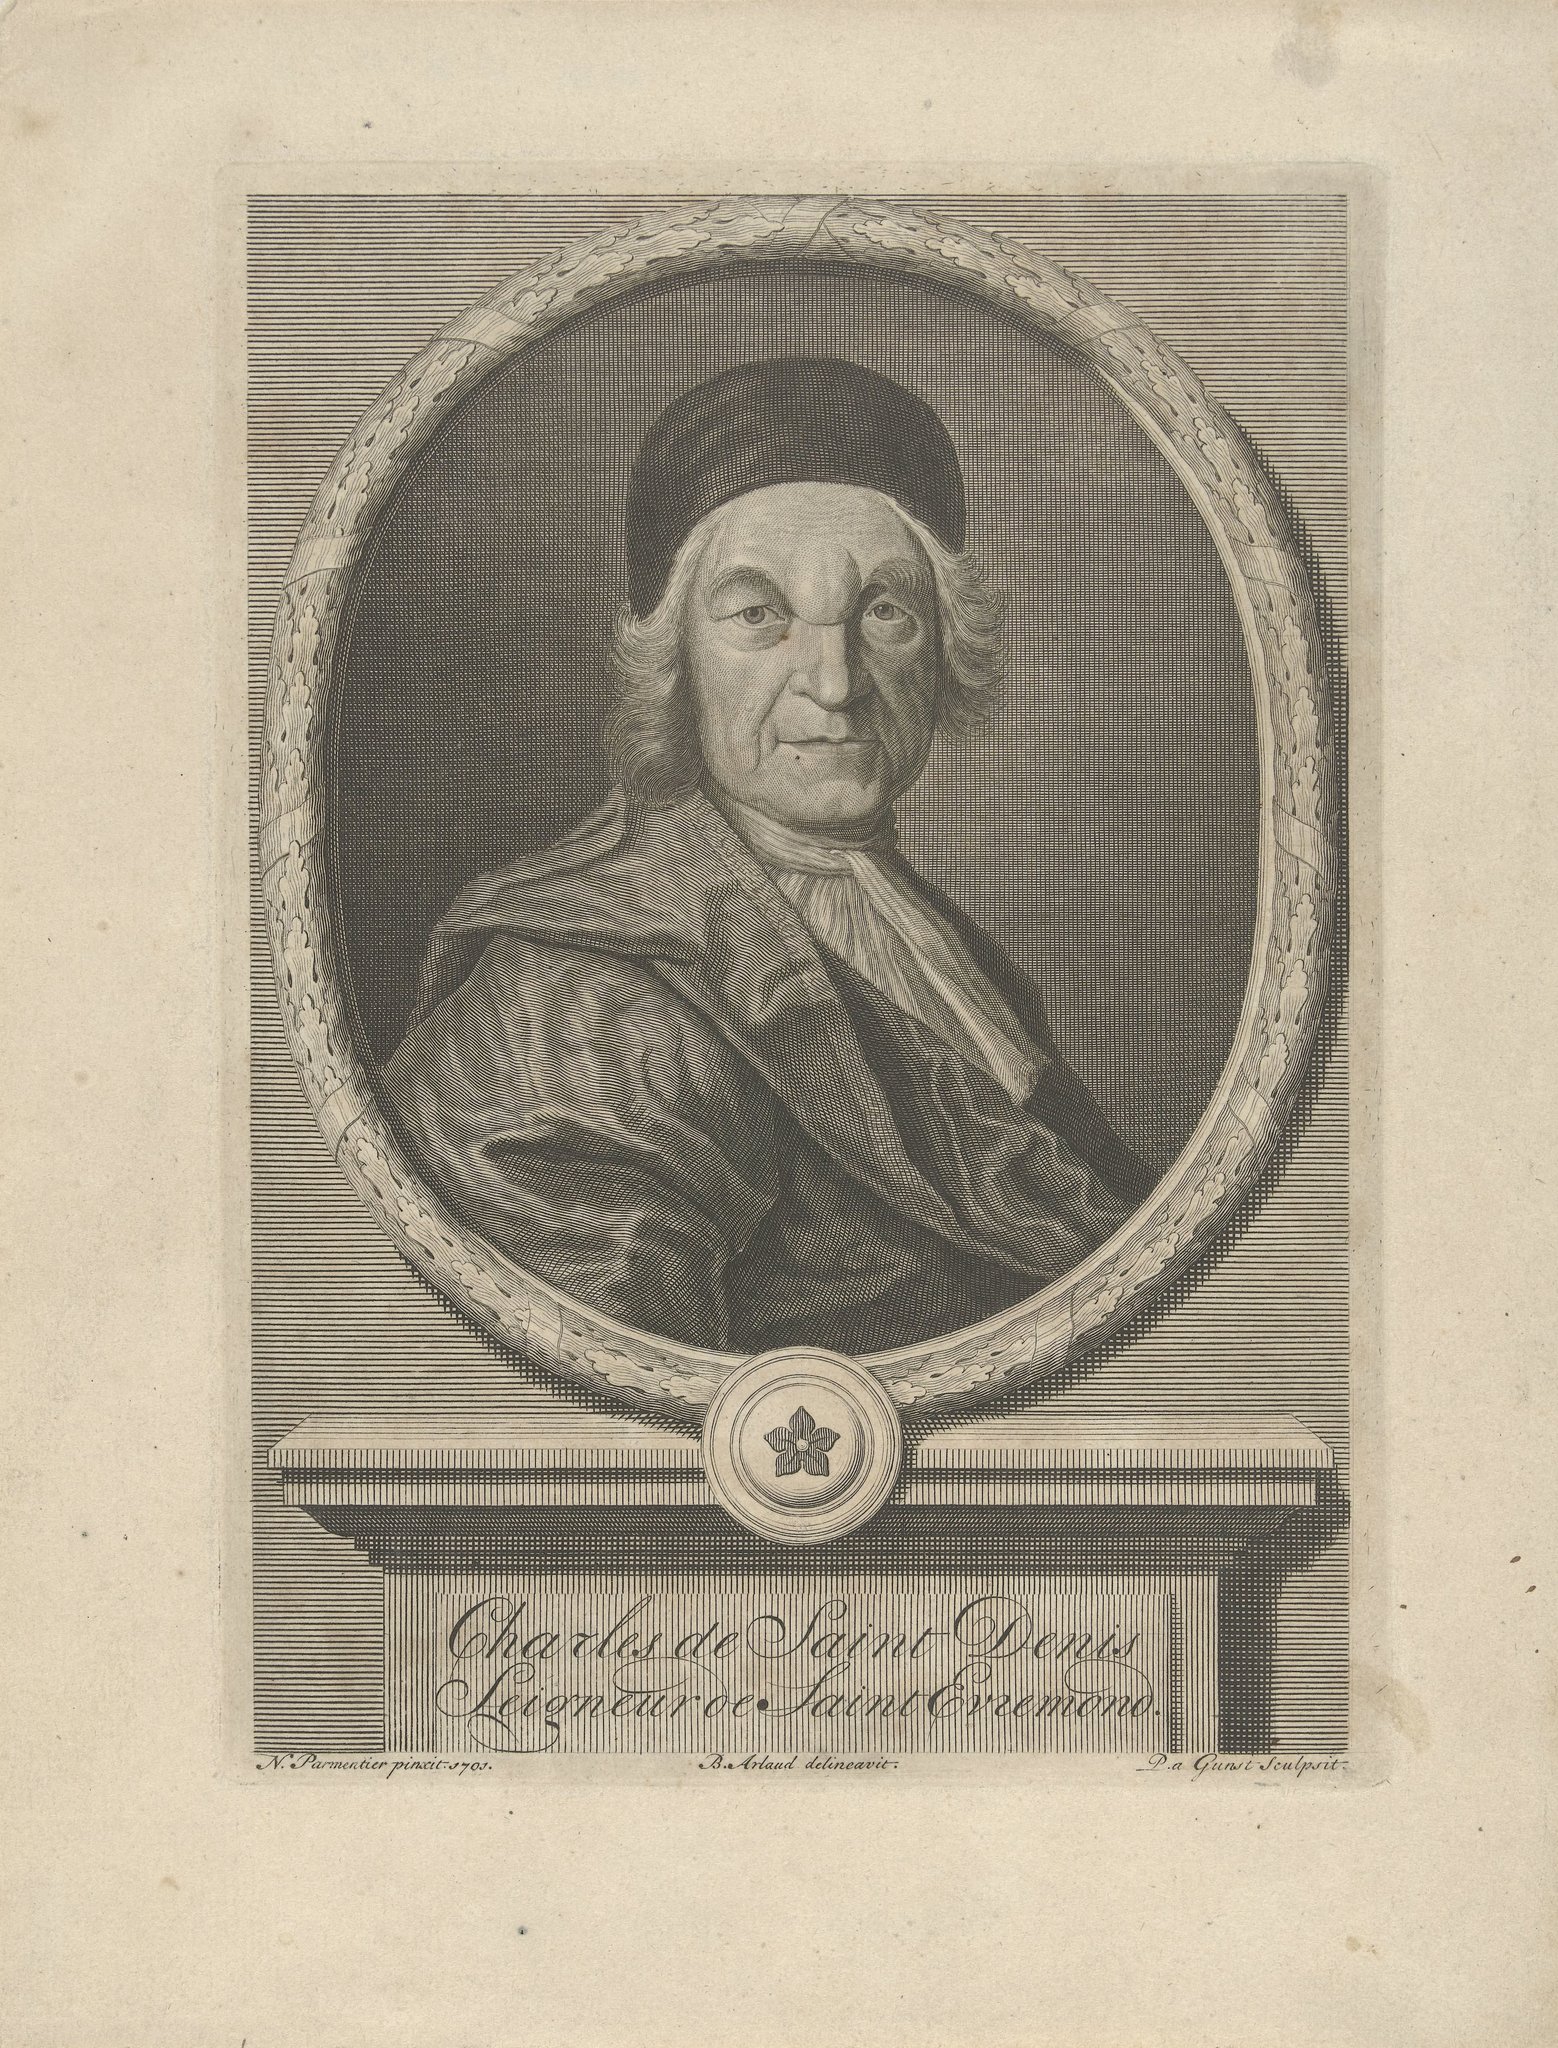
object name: print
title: Portret van Charles de Marguetel de Saint Denis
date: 1701-1731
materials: paper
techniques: engraving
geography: amsterdam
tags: england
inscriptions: collector's mark: Lugt 2760, collector's mark: Lugt 2228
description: Charles de Marguetel de Saint Denis, een Franse soldaat en schrijver die jaren in Engeland in ballingschap leefde.